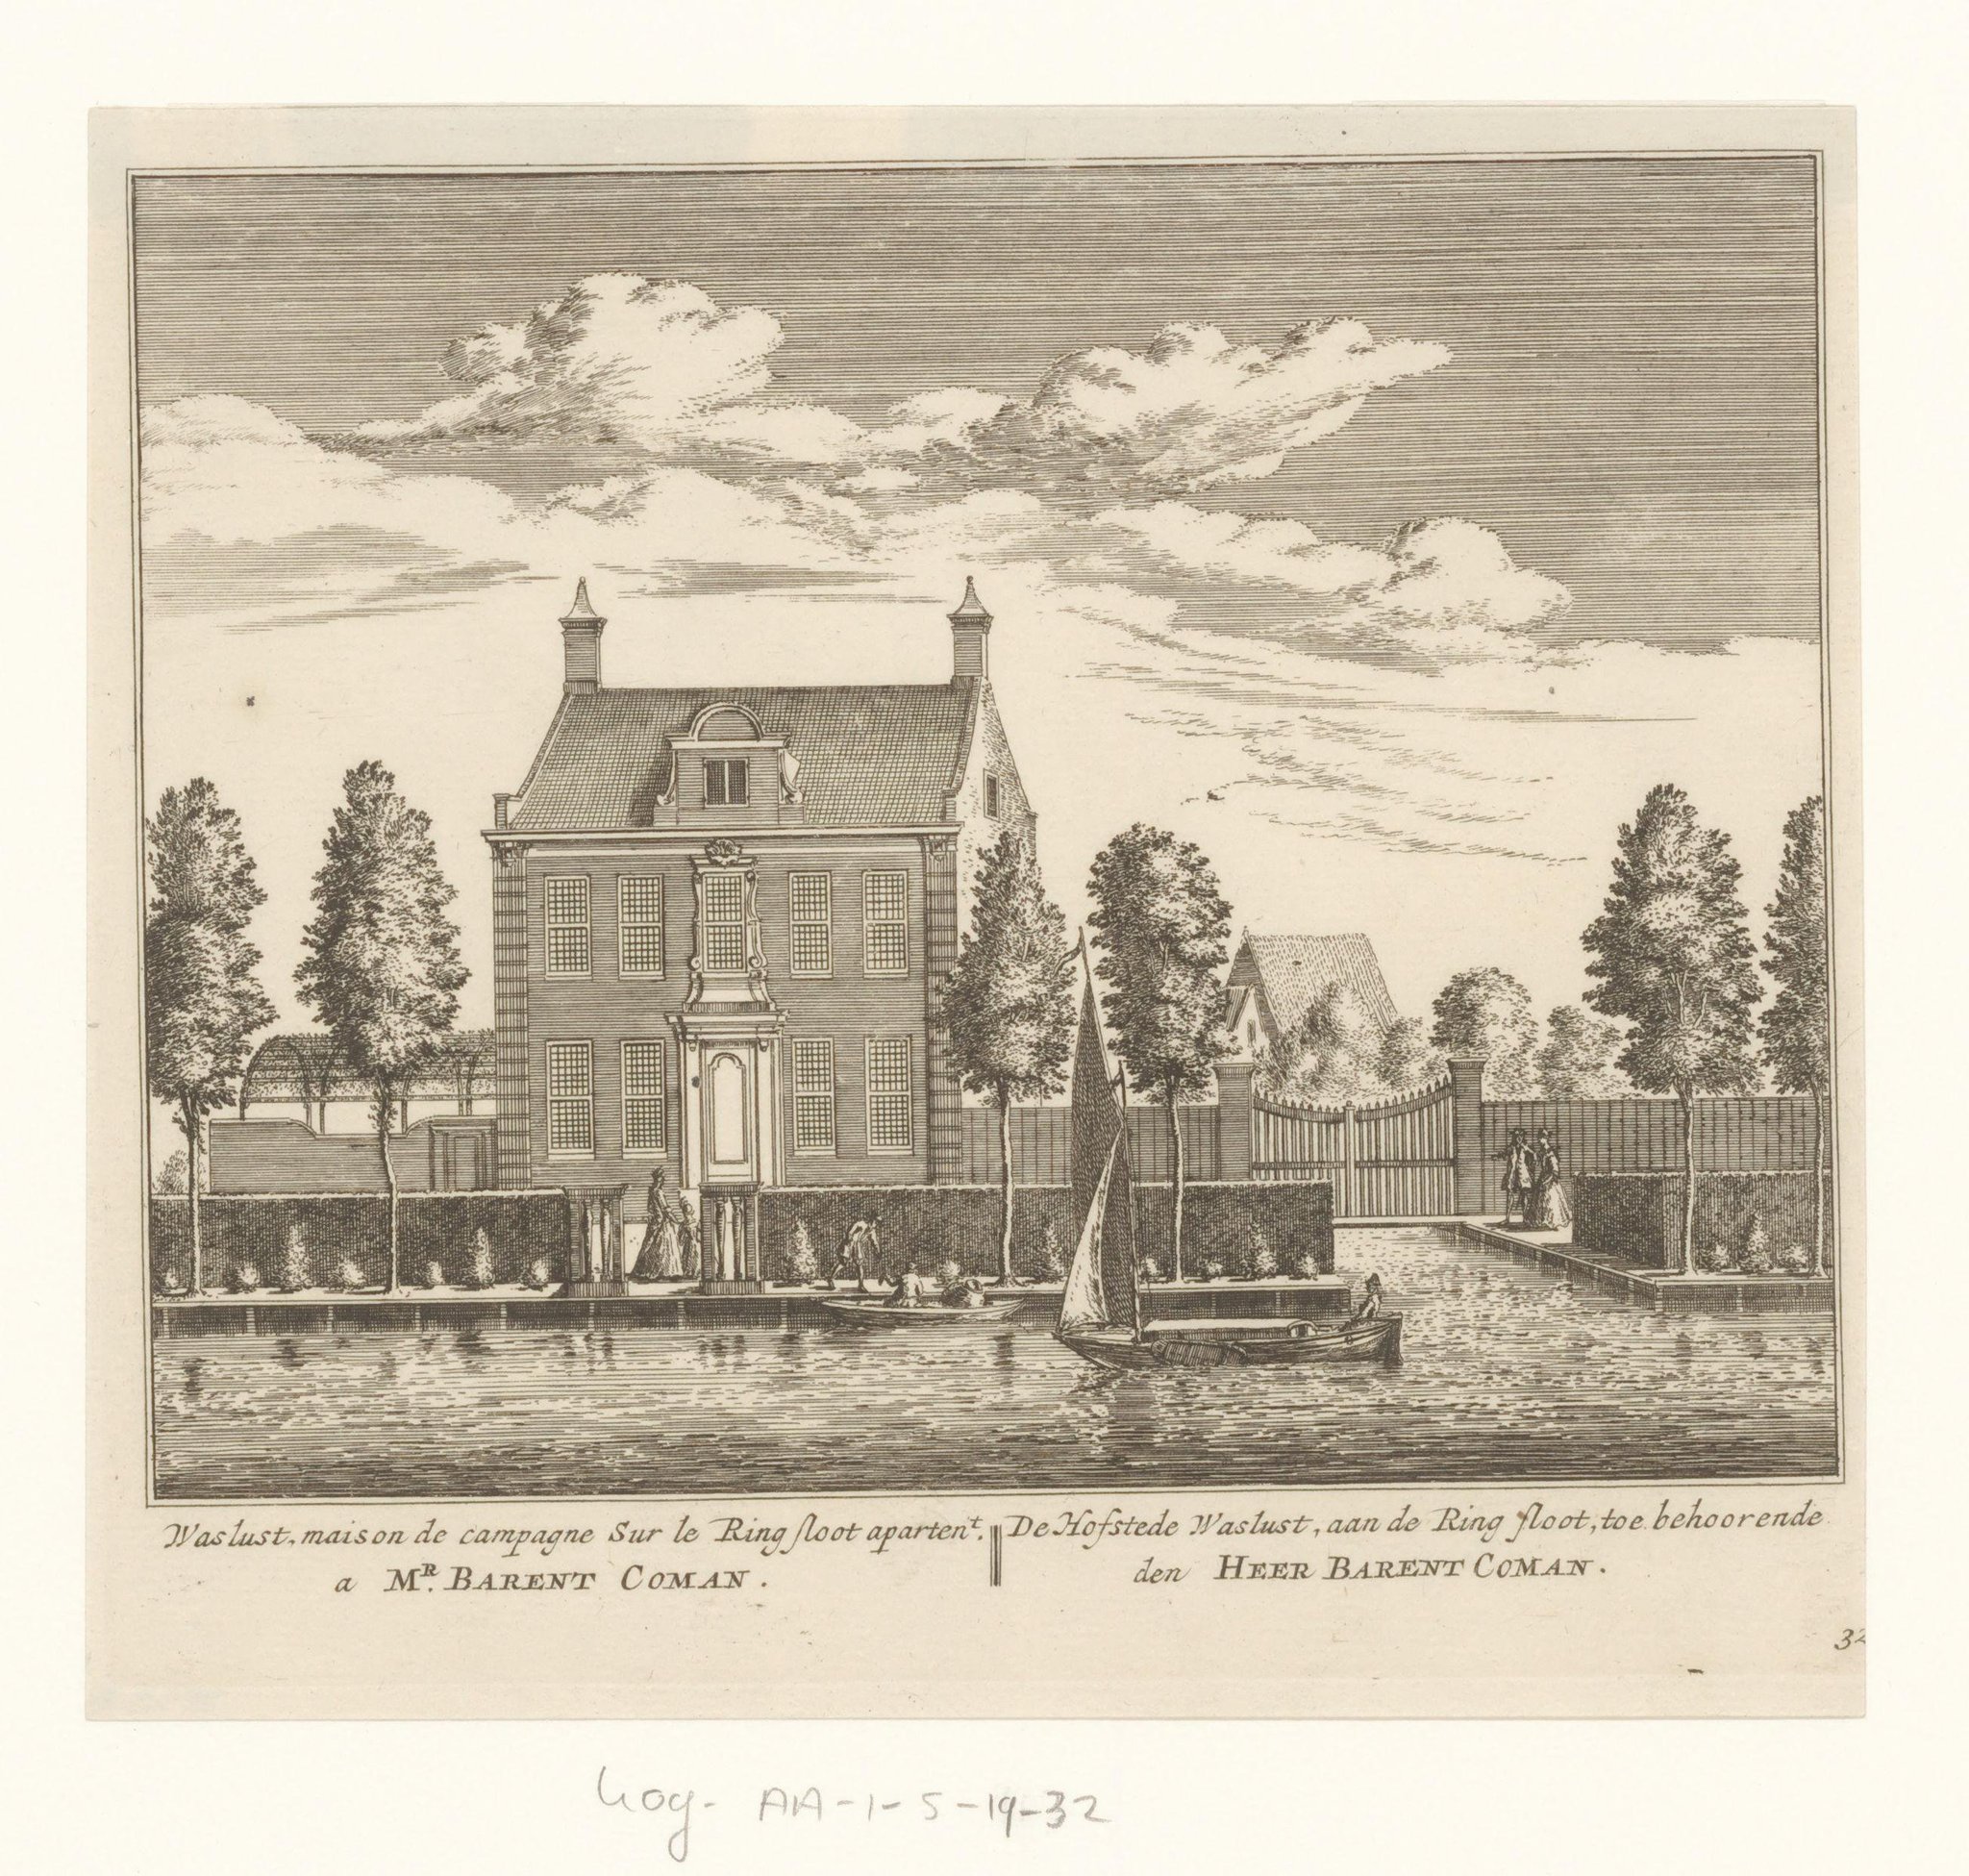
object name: print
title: De Hofstede Waslust, aan de Ring sloot, toe behoorende den Heer Barent Coman / Waslust, maison de campagne sur le Ringsloot apartent a Mr. Barent Coman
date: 1730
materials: paper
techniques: etching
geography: amsterdam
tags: sailing-ship, sailing-boat, city-view in general; 'veduta', river, rural housing, e.g. country-house, villa, cottage, amsterdam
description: Prent waarschijnlijk uit: Tijsens, Gijsbert. Hollands Arcadia, of de vermaarde rivier den Amstel (...) naar 't léven getekend en in 't ligt gebragt door Abraham Rademaker (...). Amsterdam: Leonardus Schenk, 1730.